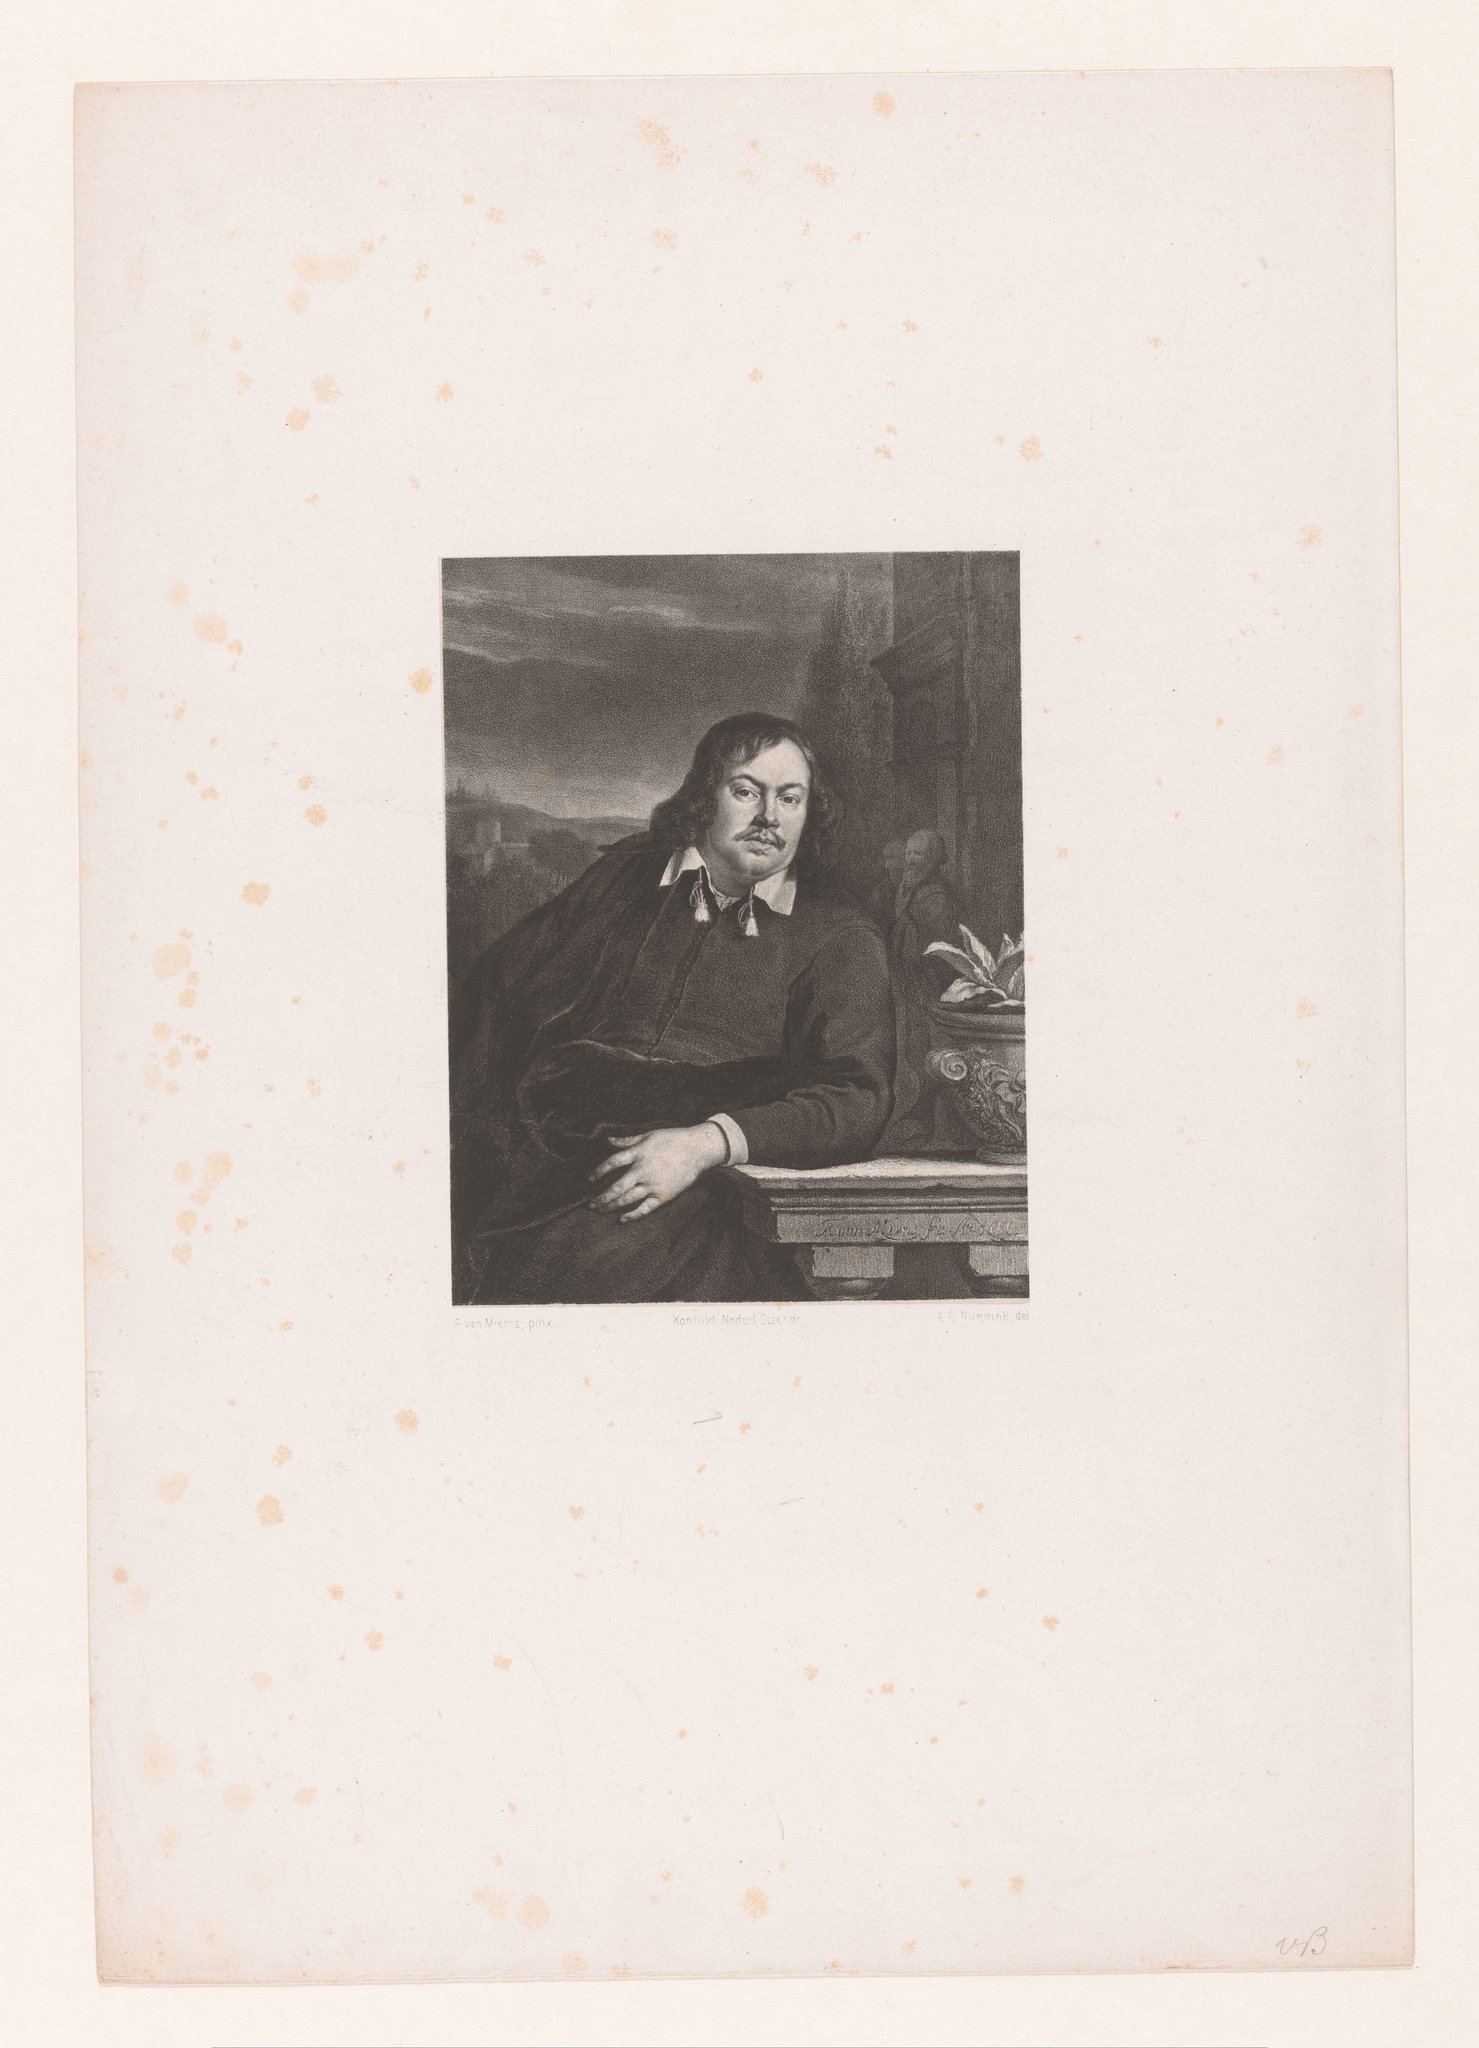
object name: print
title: Portret van Florentius Schuyl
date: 1867-1874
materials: paper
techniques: lithograph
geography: the hague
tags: historical persons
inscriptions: collector's mark: Lugt 2228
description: Prent naar Portret van Florentius Schuyl (1666) van Frans van Mieris (I) in de collectie van het Mauritshuis te Den Haag.